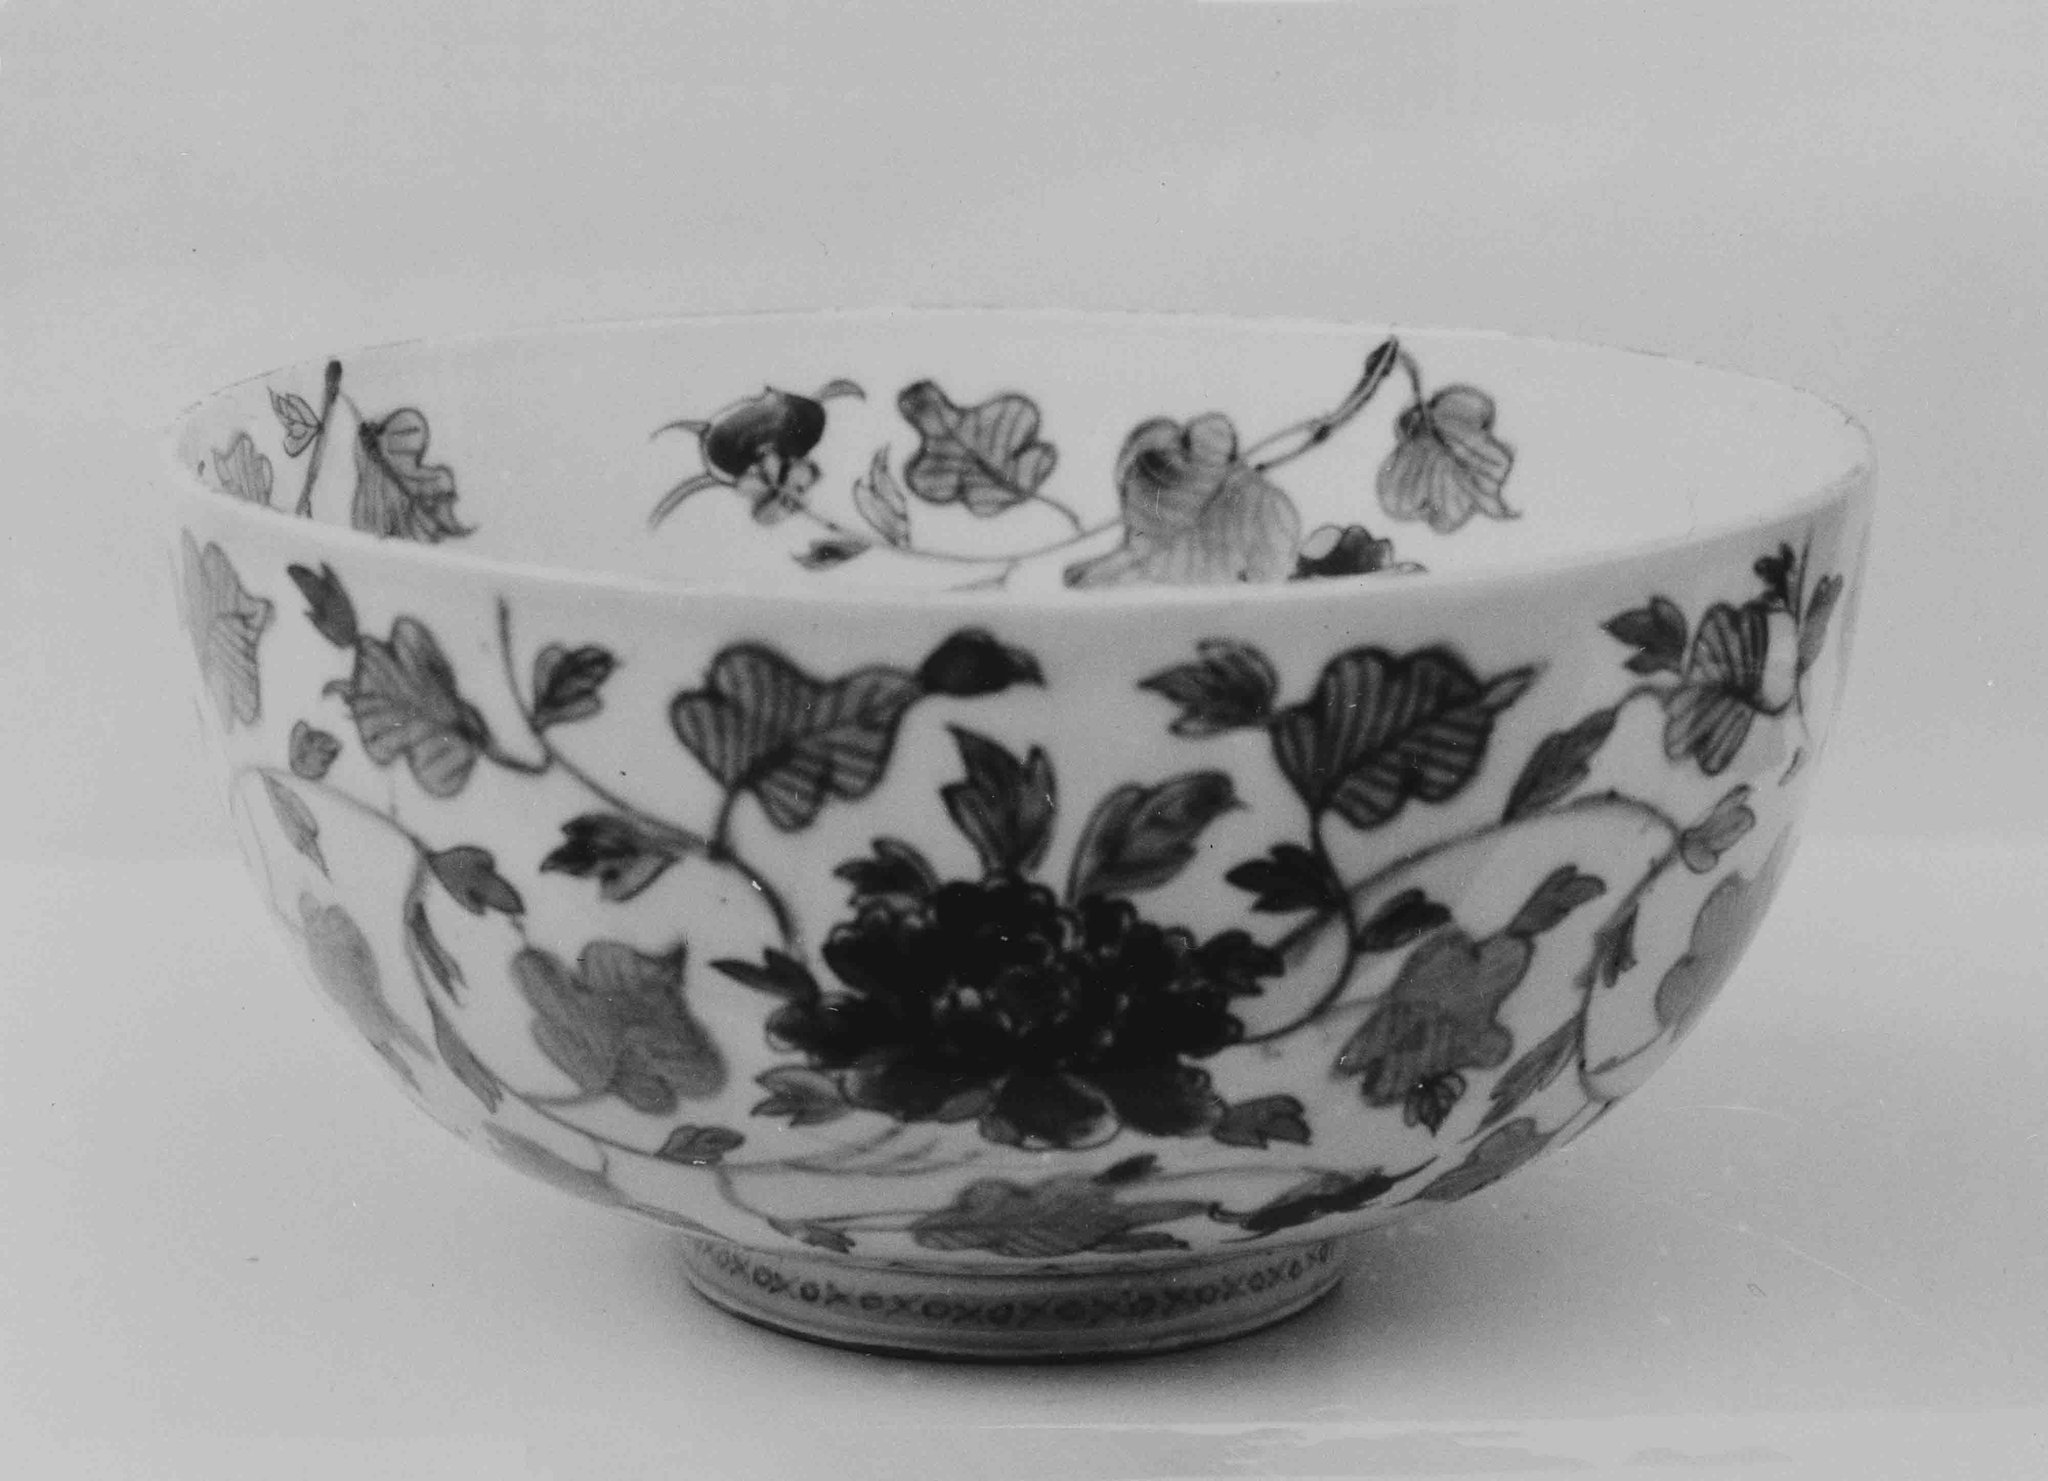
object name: bowl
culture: japanese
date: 1780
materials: enamel, porcelain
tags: flowers,leaves